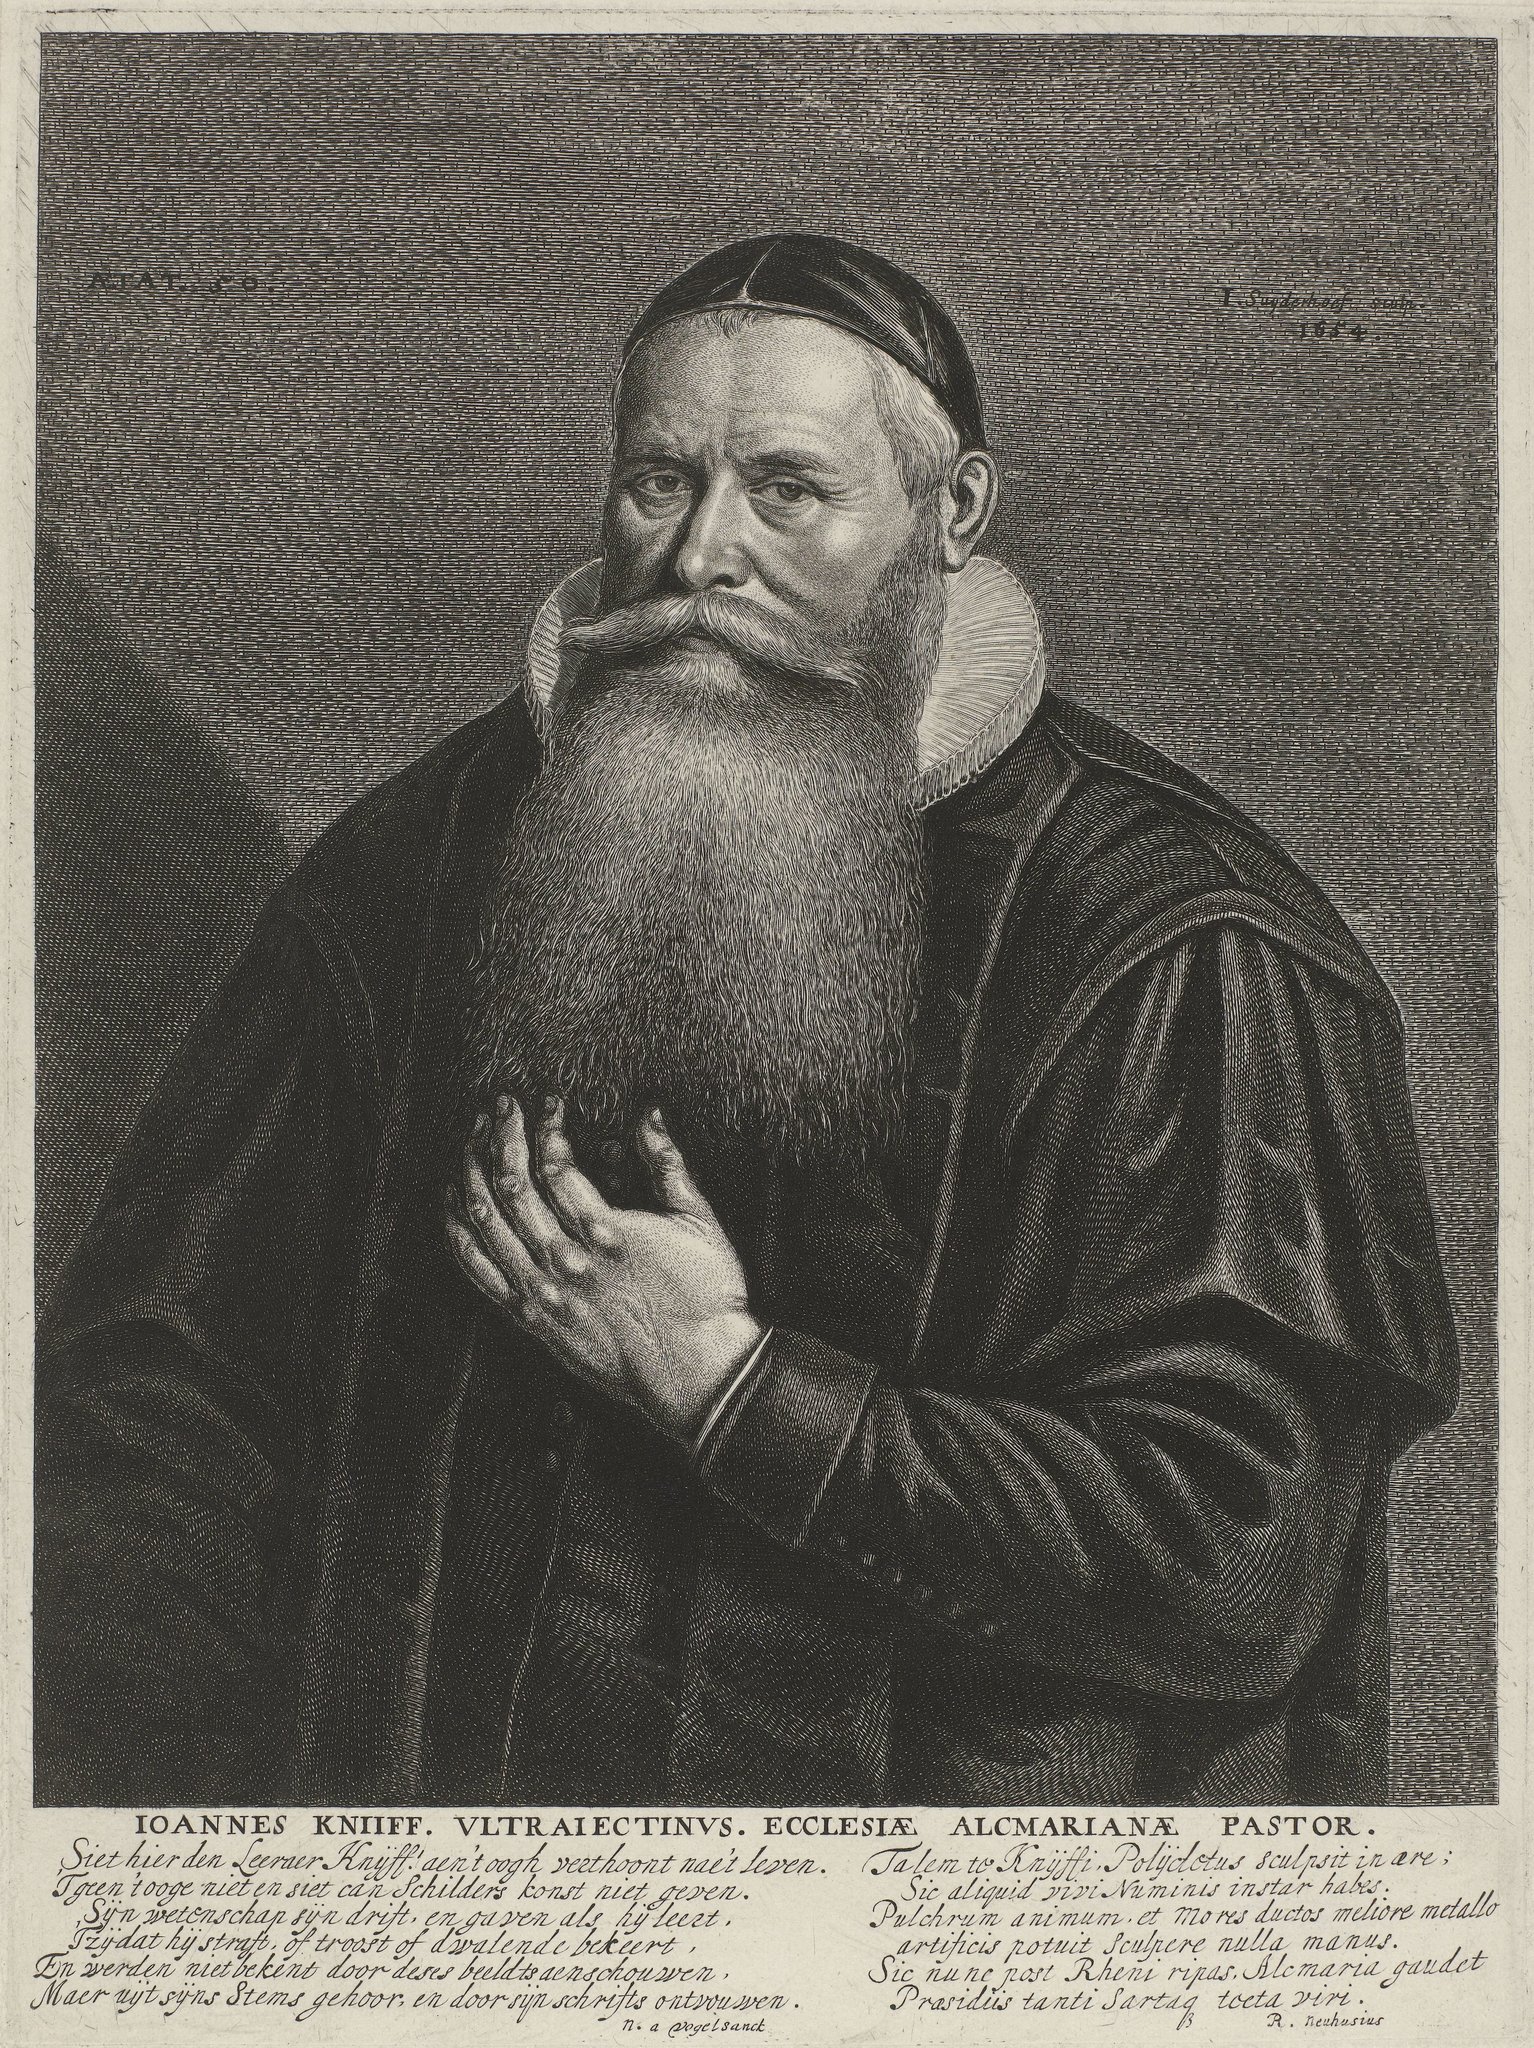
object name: print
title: Portret van Johannes Knijff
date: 1654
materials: paper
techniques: engraving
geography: haarlem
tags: utrecht, functionaries and dignitaries ~ protestant churches, beard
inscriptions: collector's mark: Lugt 2228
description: Portret van Johannes Knijff, predikant te Alkmaar, op 50-jarige leeftijd. Onderaan in de marge zijn naam en functie in het Latijn en een zesregelig vers in het Nederlands en in het Latijn.